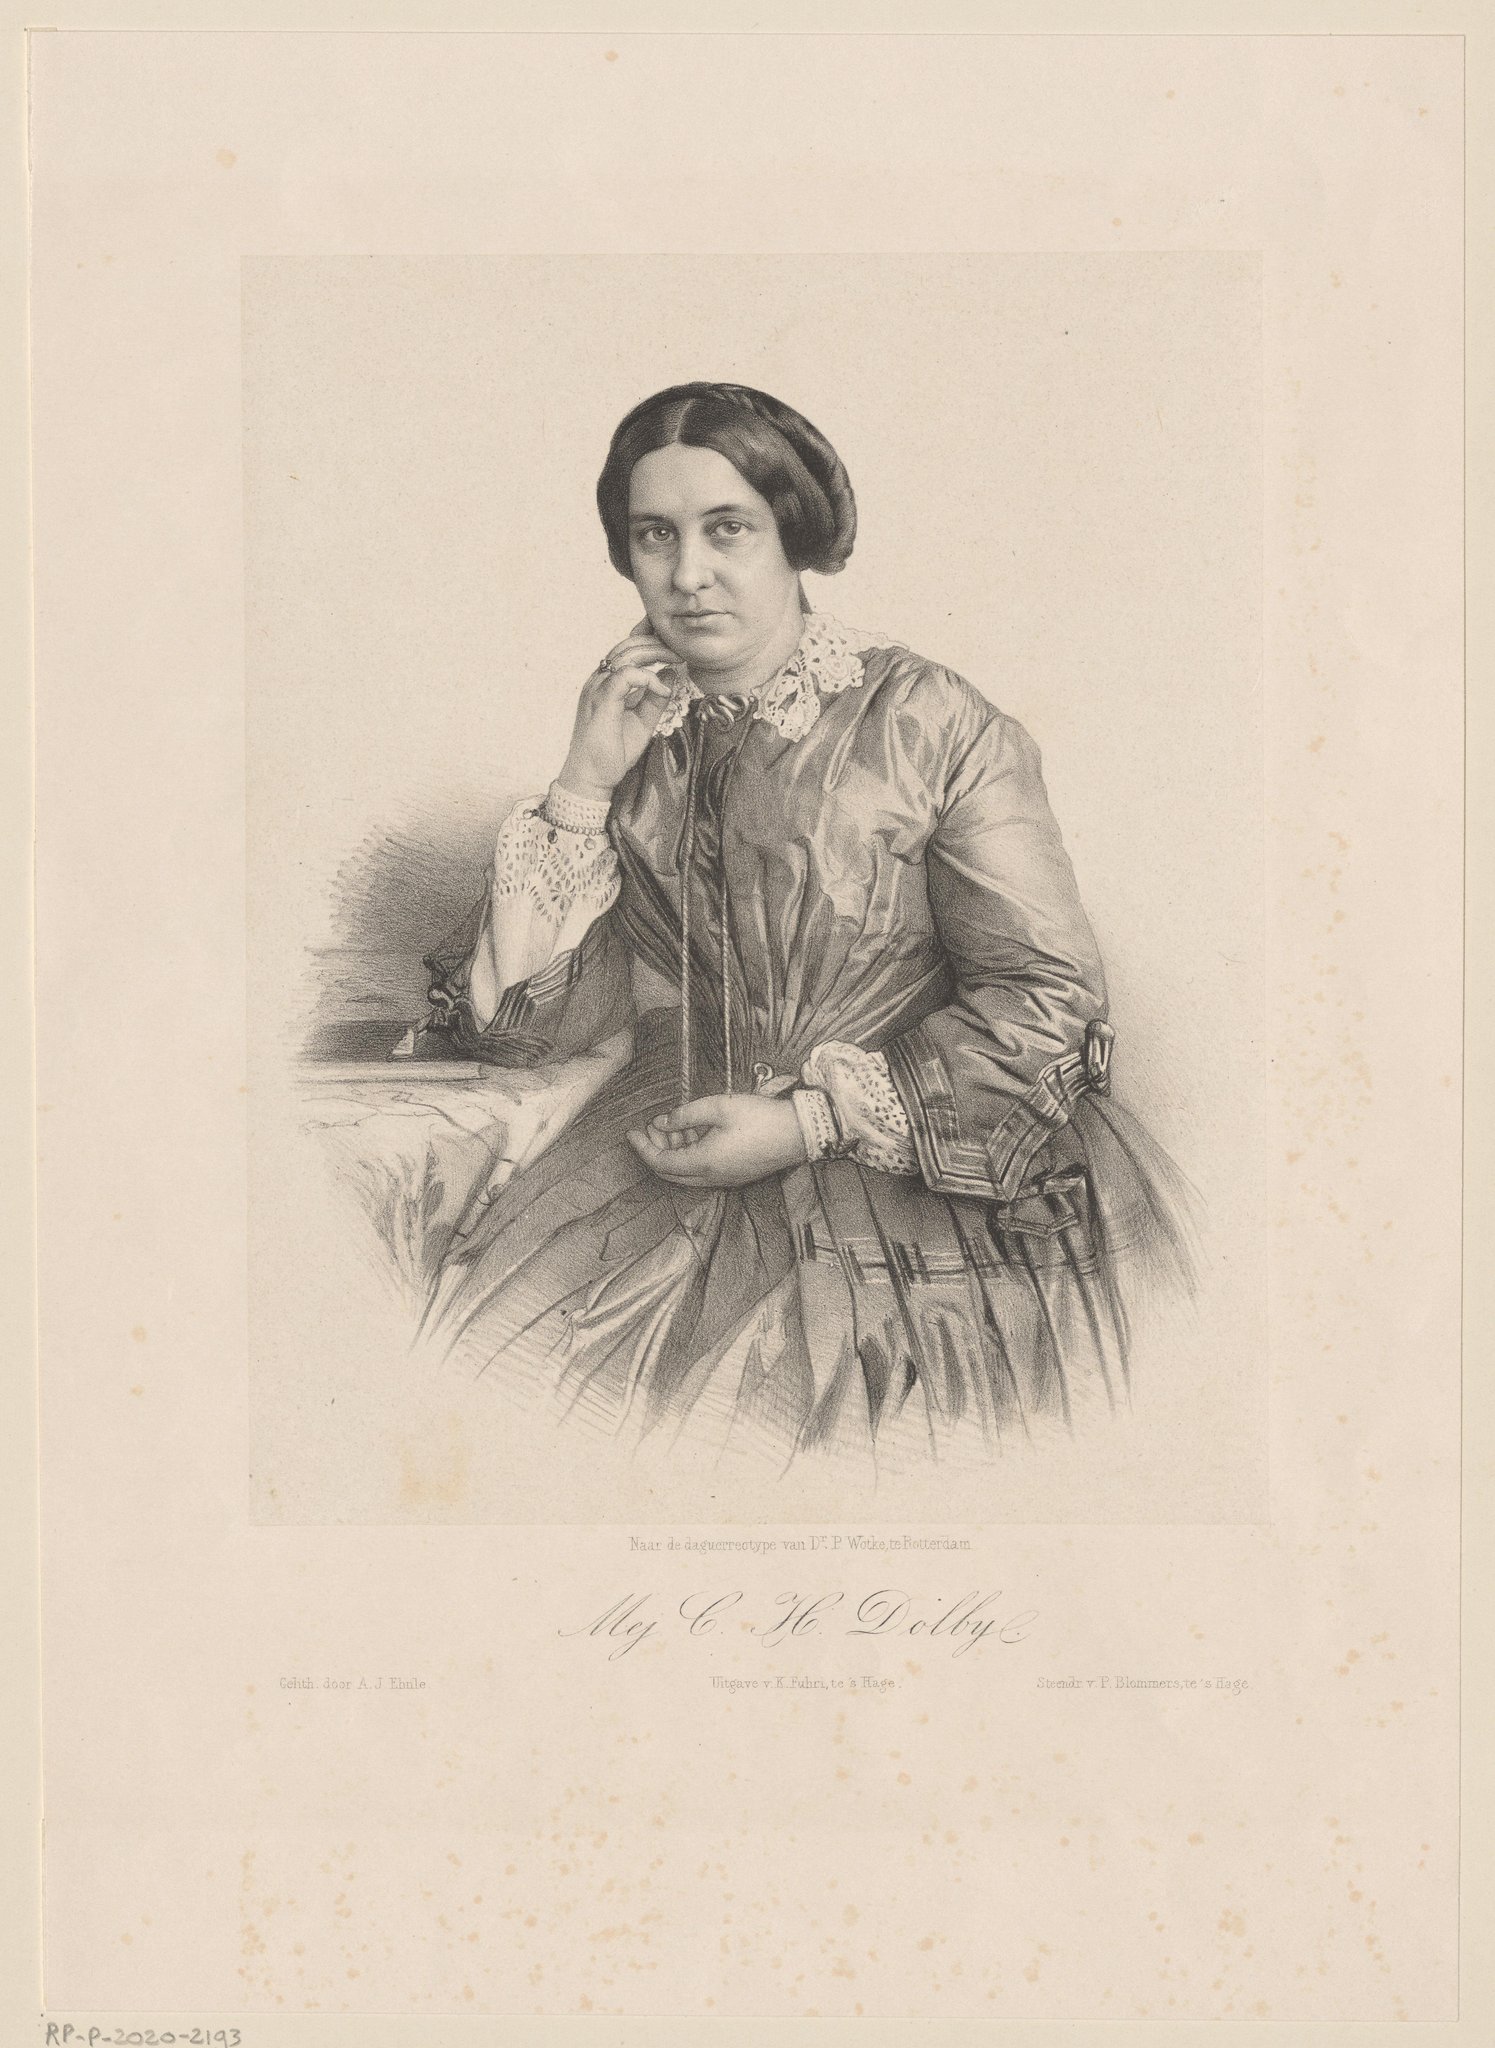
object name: print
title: Maatschappij ter Bevordering van Toonkunst, haar Muziekfeest en de stad Rotterdam. Herinnering aan het jaar 1854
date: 1855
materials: paper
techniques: lithograph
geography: the hague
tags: historical persons